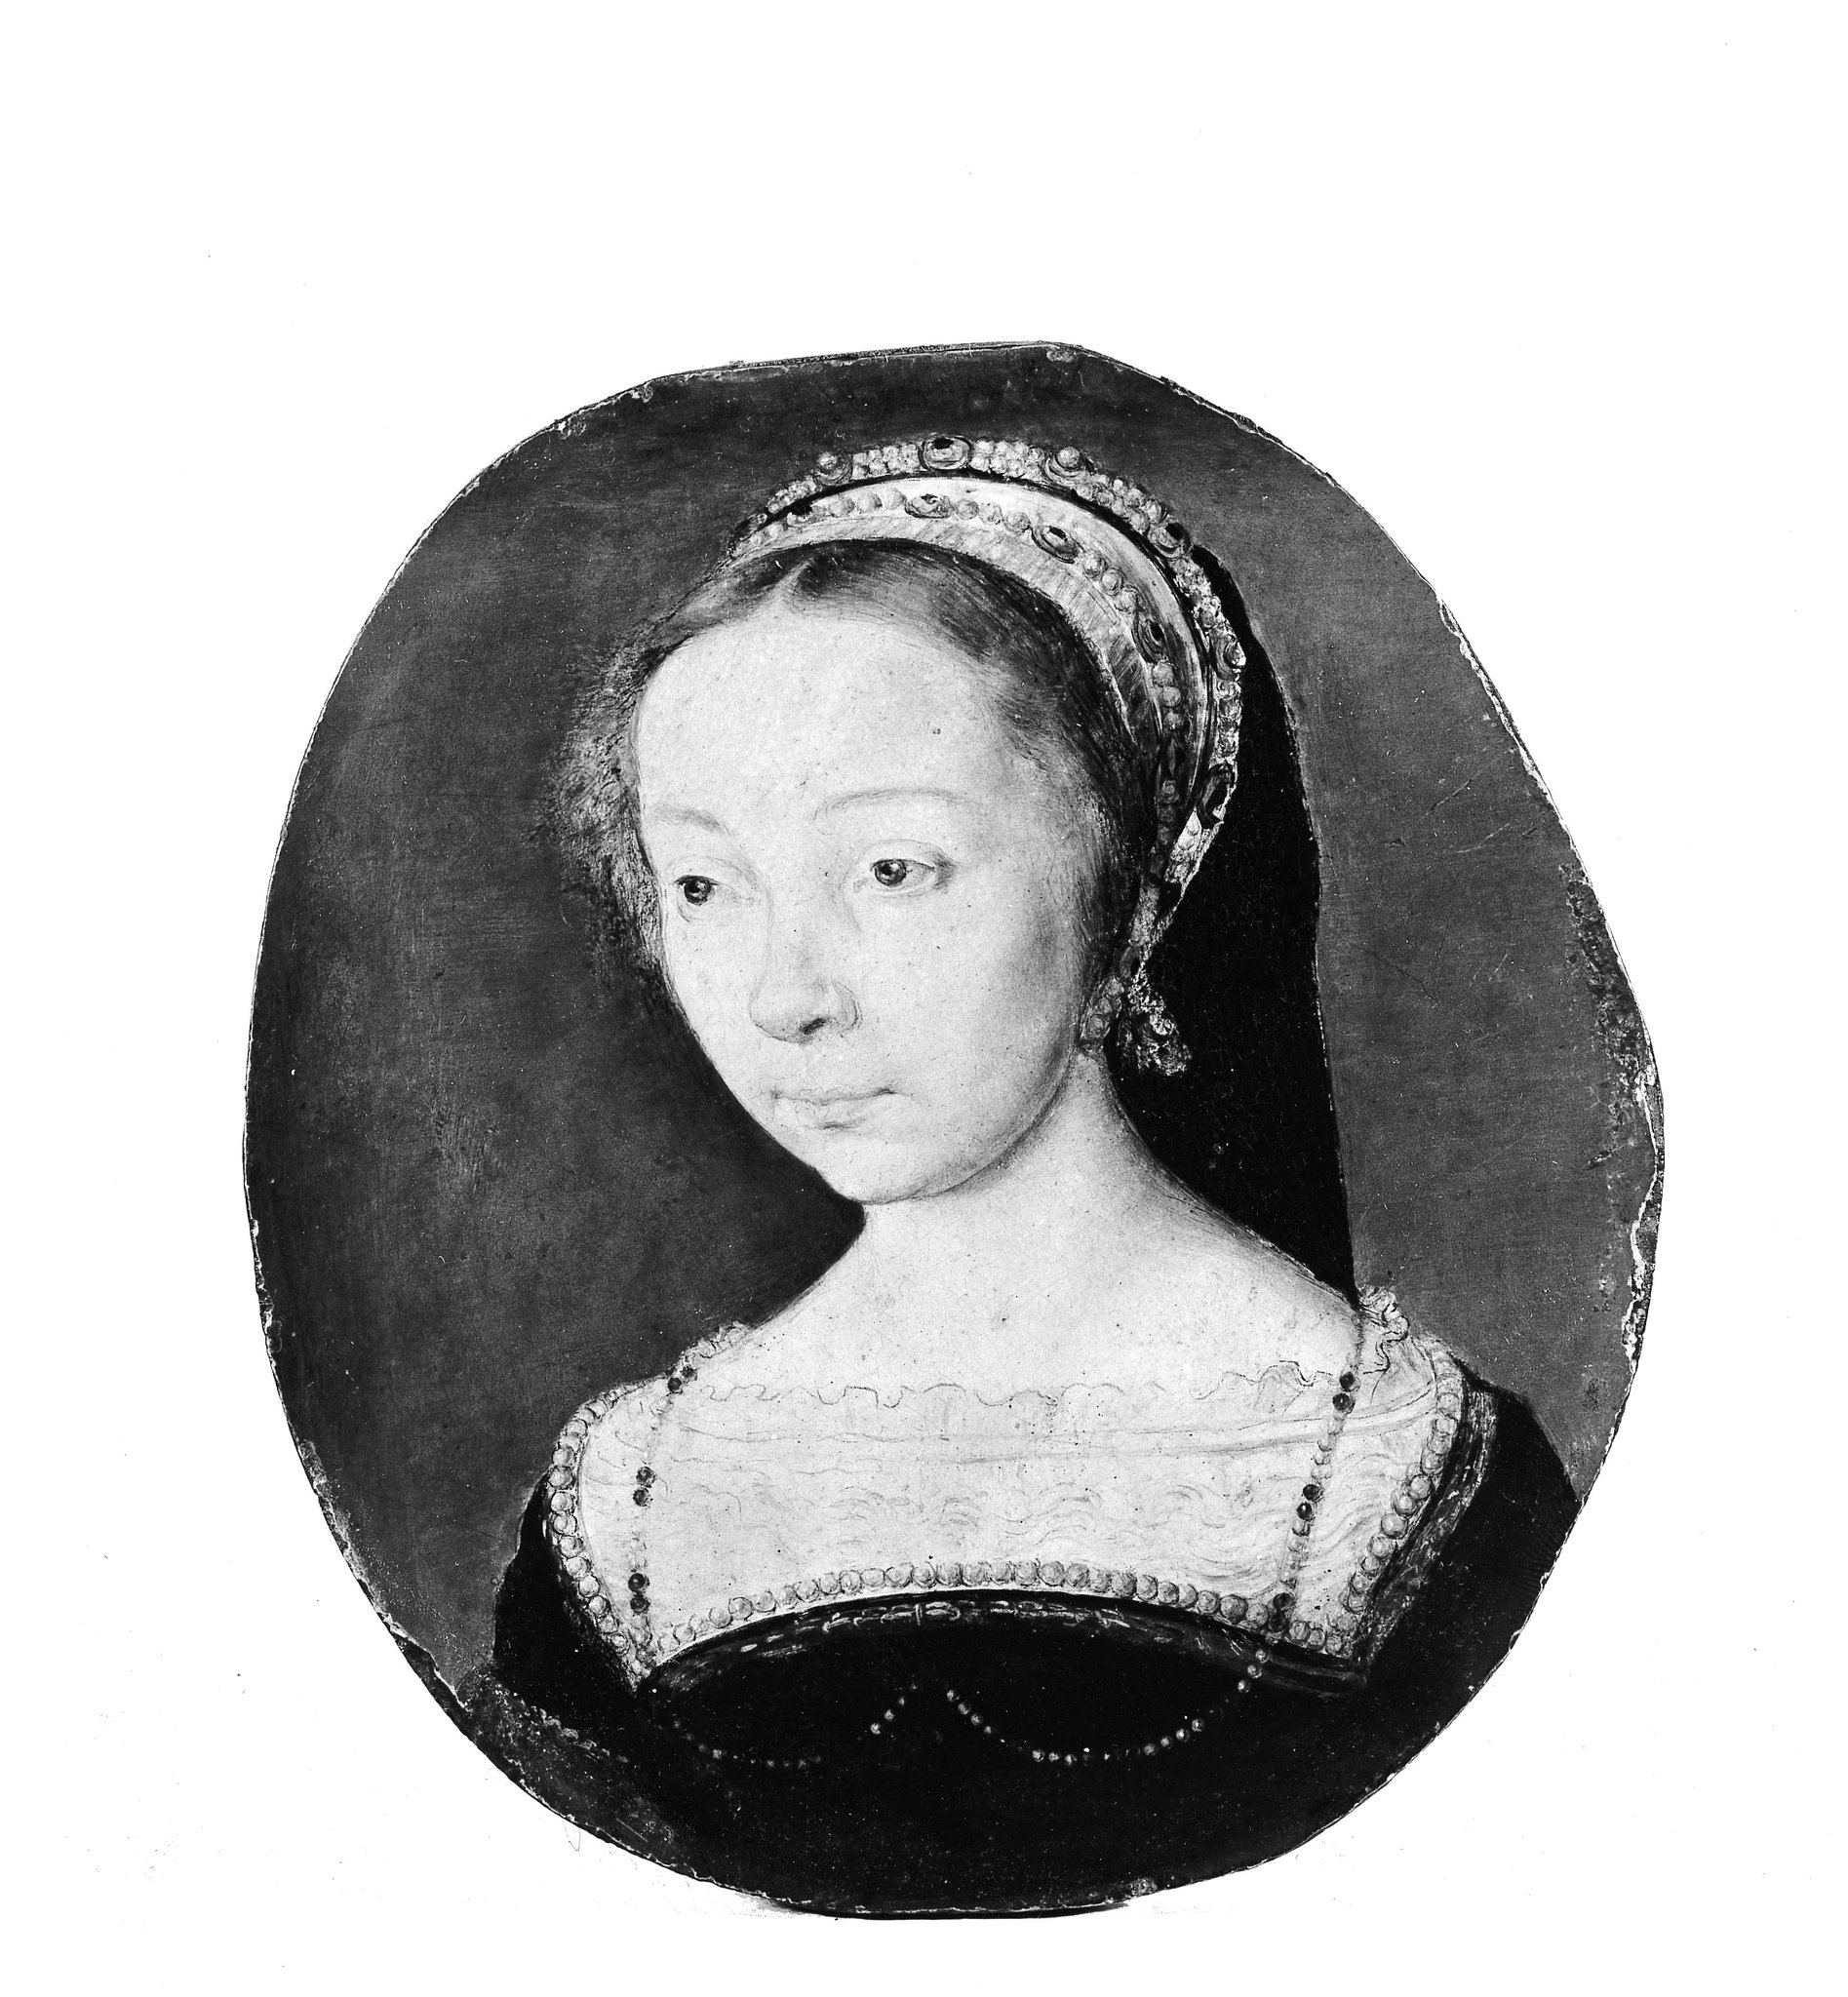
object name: painting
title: Portrait of a Young Woman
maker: corneille de lyon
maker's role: artist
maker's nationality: netherlandish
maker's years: 1533-1575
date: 1533-1575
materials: oil, wood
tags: portraits,women